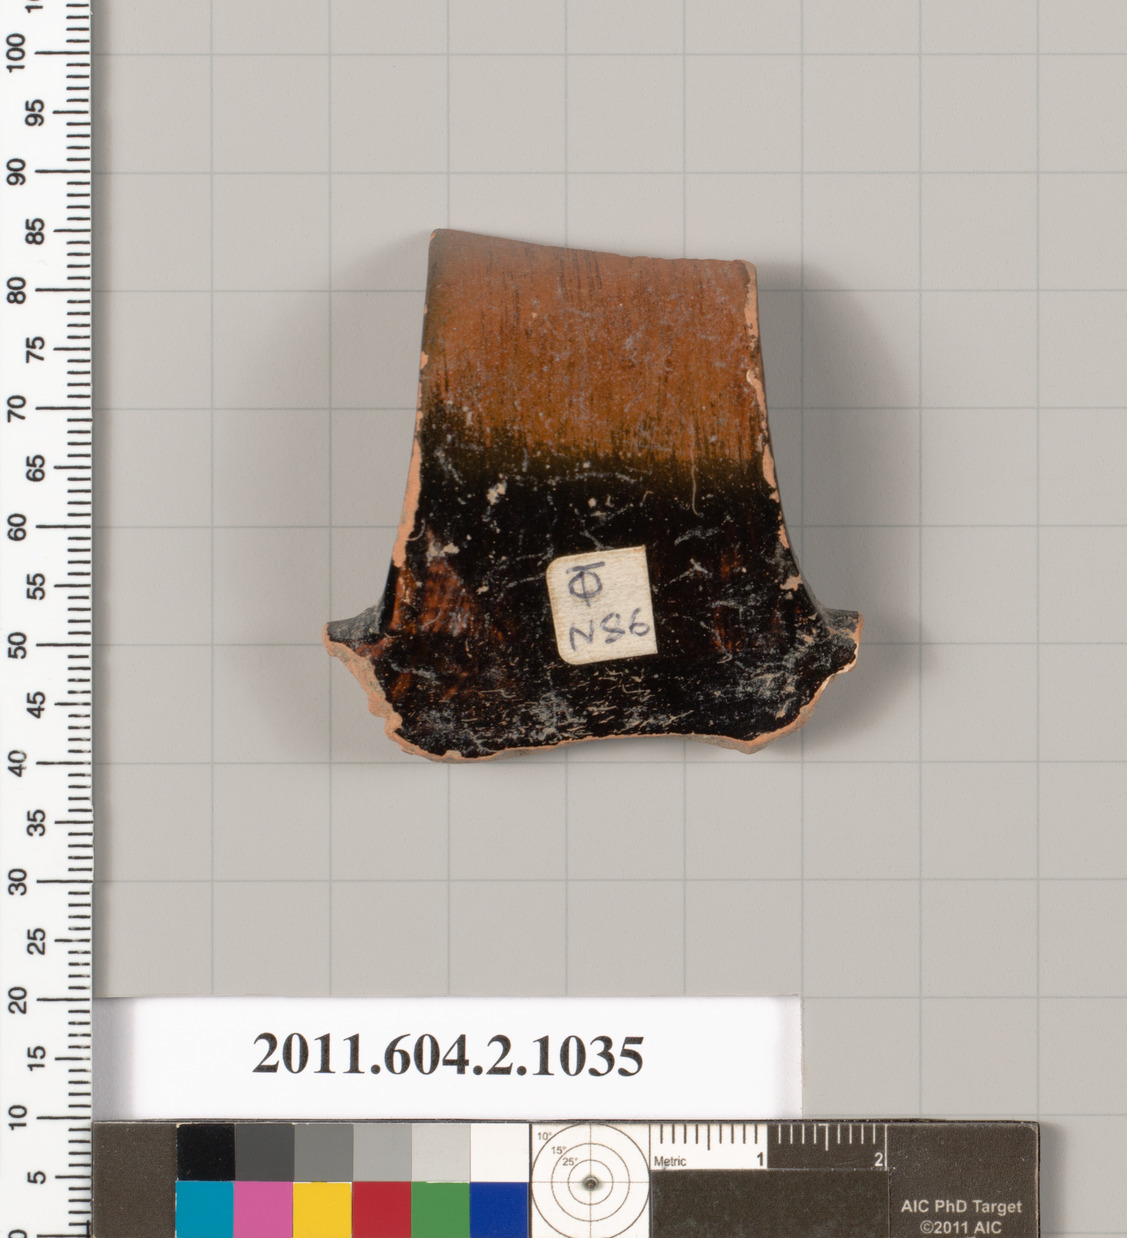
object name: oinochoe fragment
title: Terracotta fragment of an oinochoe (jug)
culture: greek, attic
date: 475-425 BCE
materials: terracotta